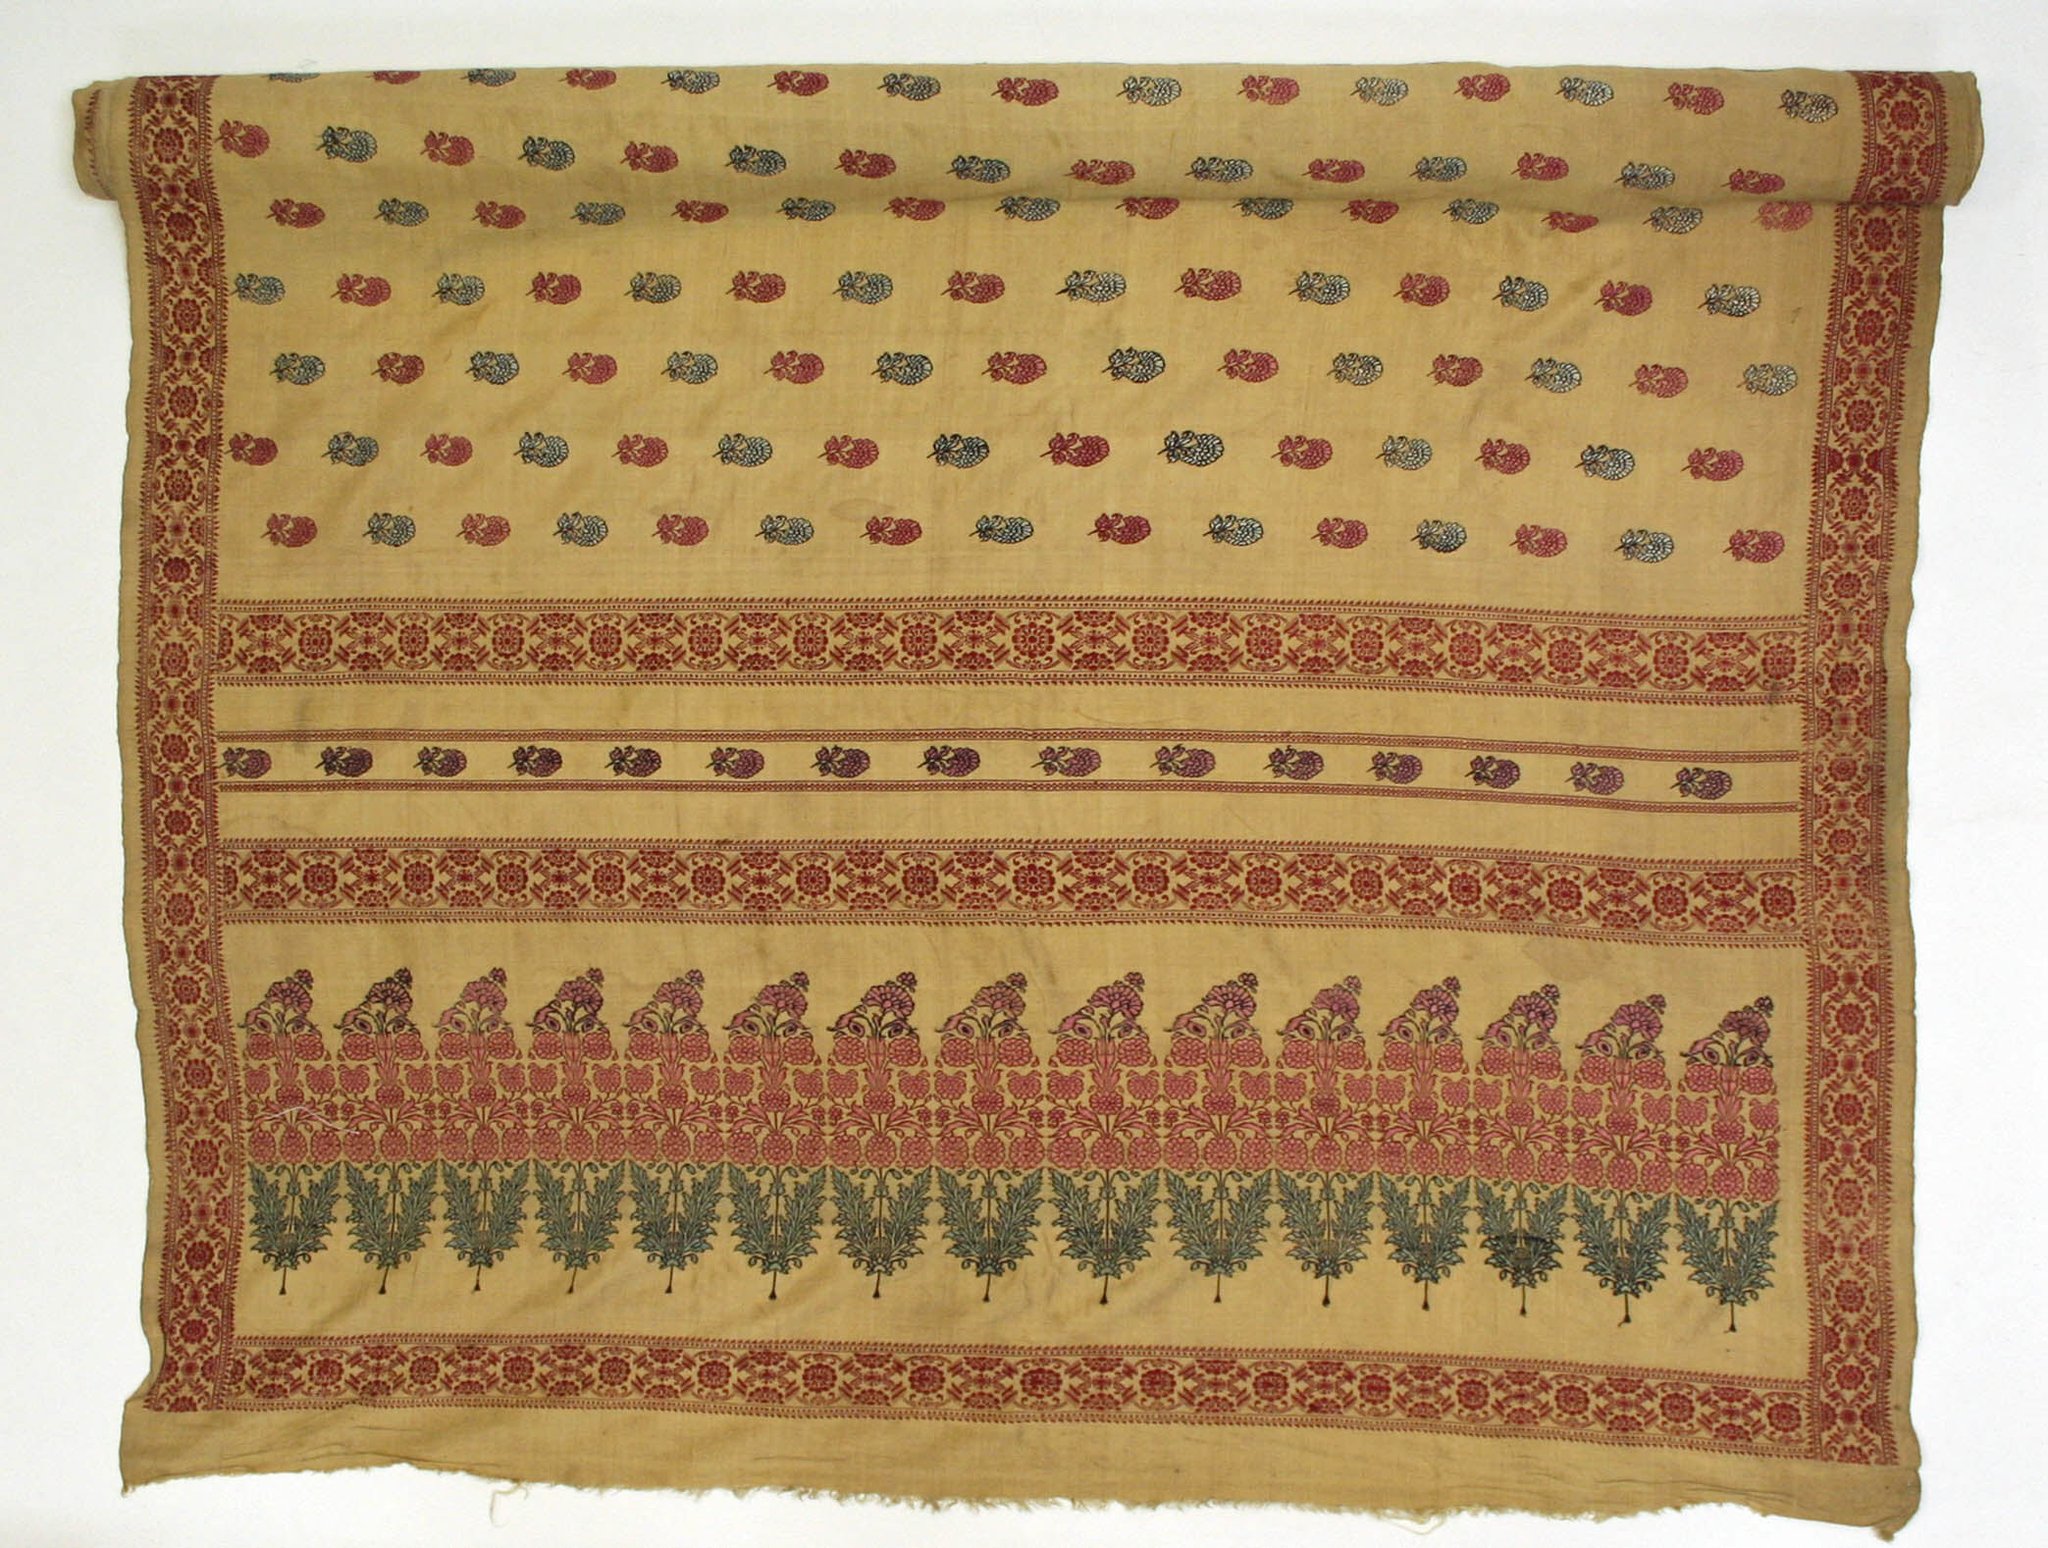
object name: sari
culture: indian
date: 1801-1900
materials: metal thread, silk